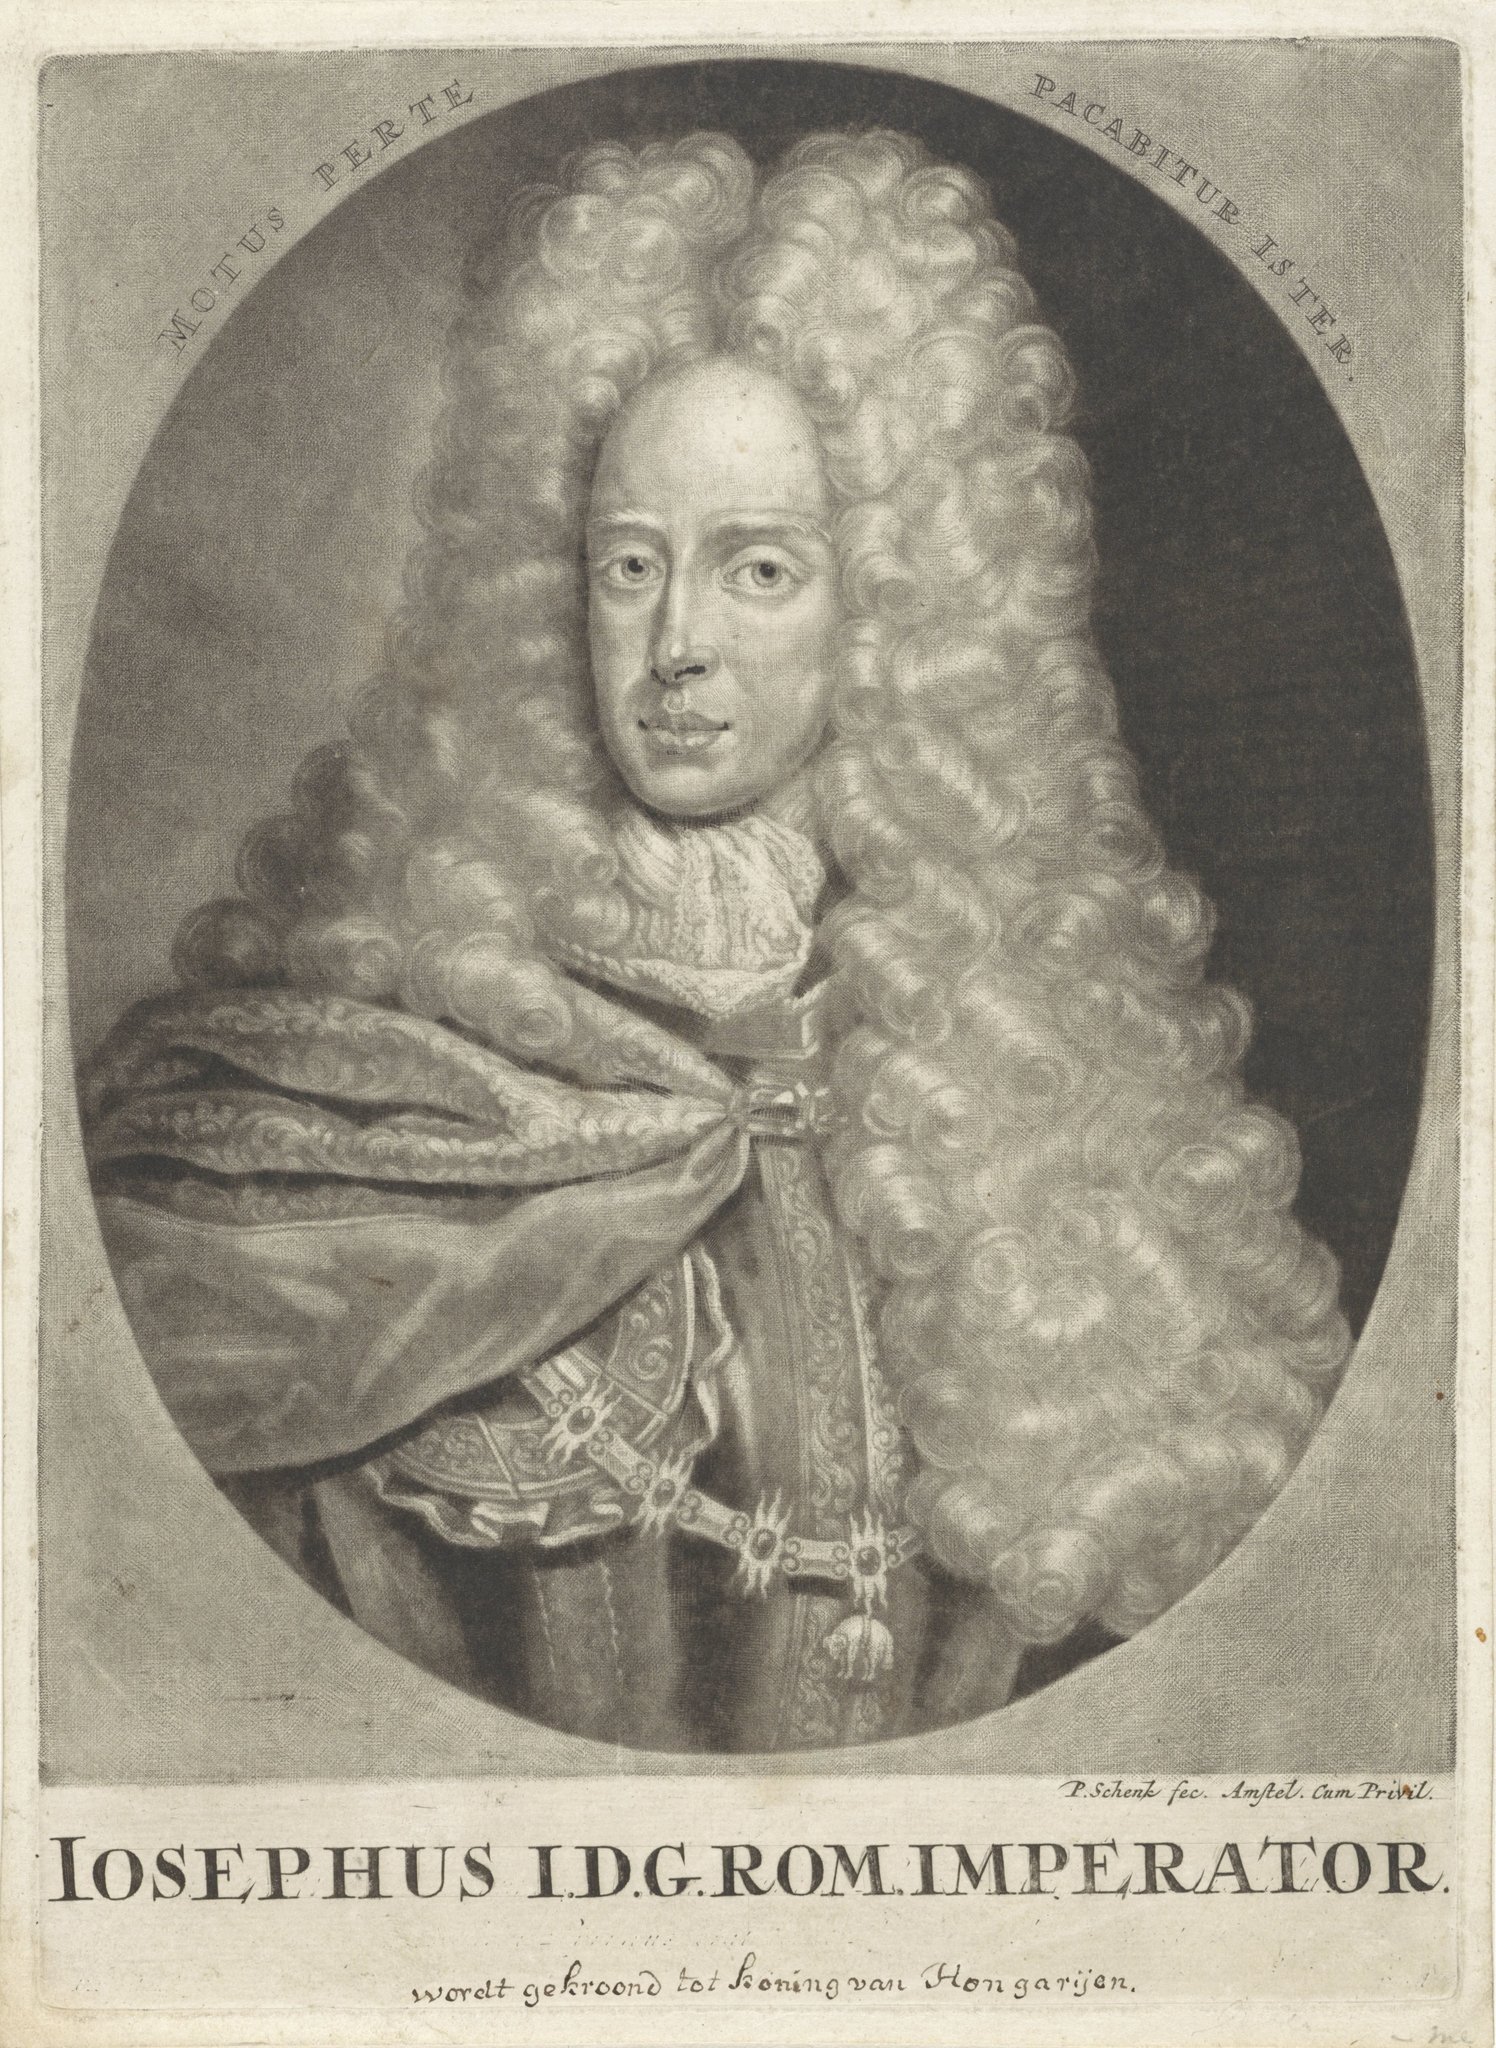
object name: print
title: Portret van keizer Jozef I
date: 1690-1713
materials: paper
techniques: engraving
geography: amsterdam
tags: vienna, jozef i (duits keizer), knighthood order of the golden fleece, wig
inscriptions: collector's mark: Lugt 2228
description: Portret van Jozef I, keizer van het Heilig Roomse Rijk en koning van Hongarije. Om zijn hals een keten met het teken van de Orde van het Gulden Vlies. Hij draagt een lange krulpruik